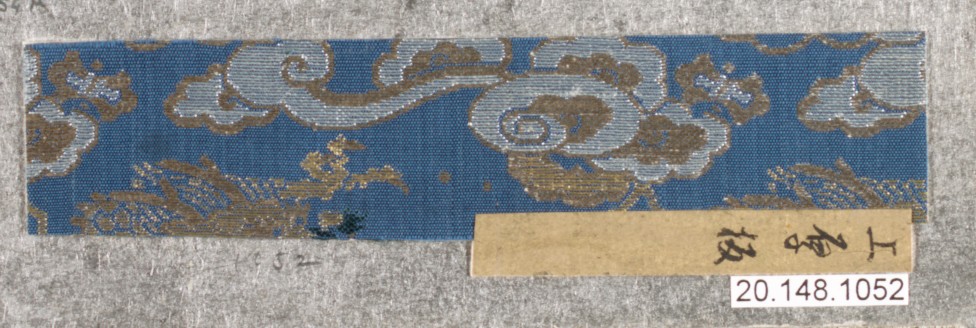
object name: piece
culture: japanese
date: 1701-1800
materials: silk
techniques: compound weave